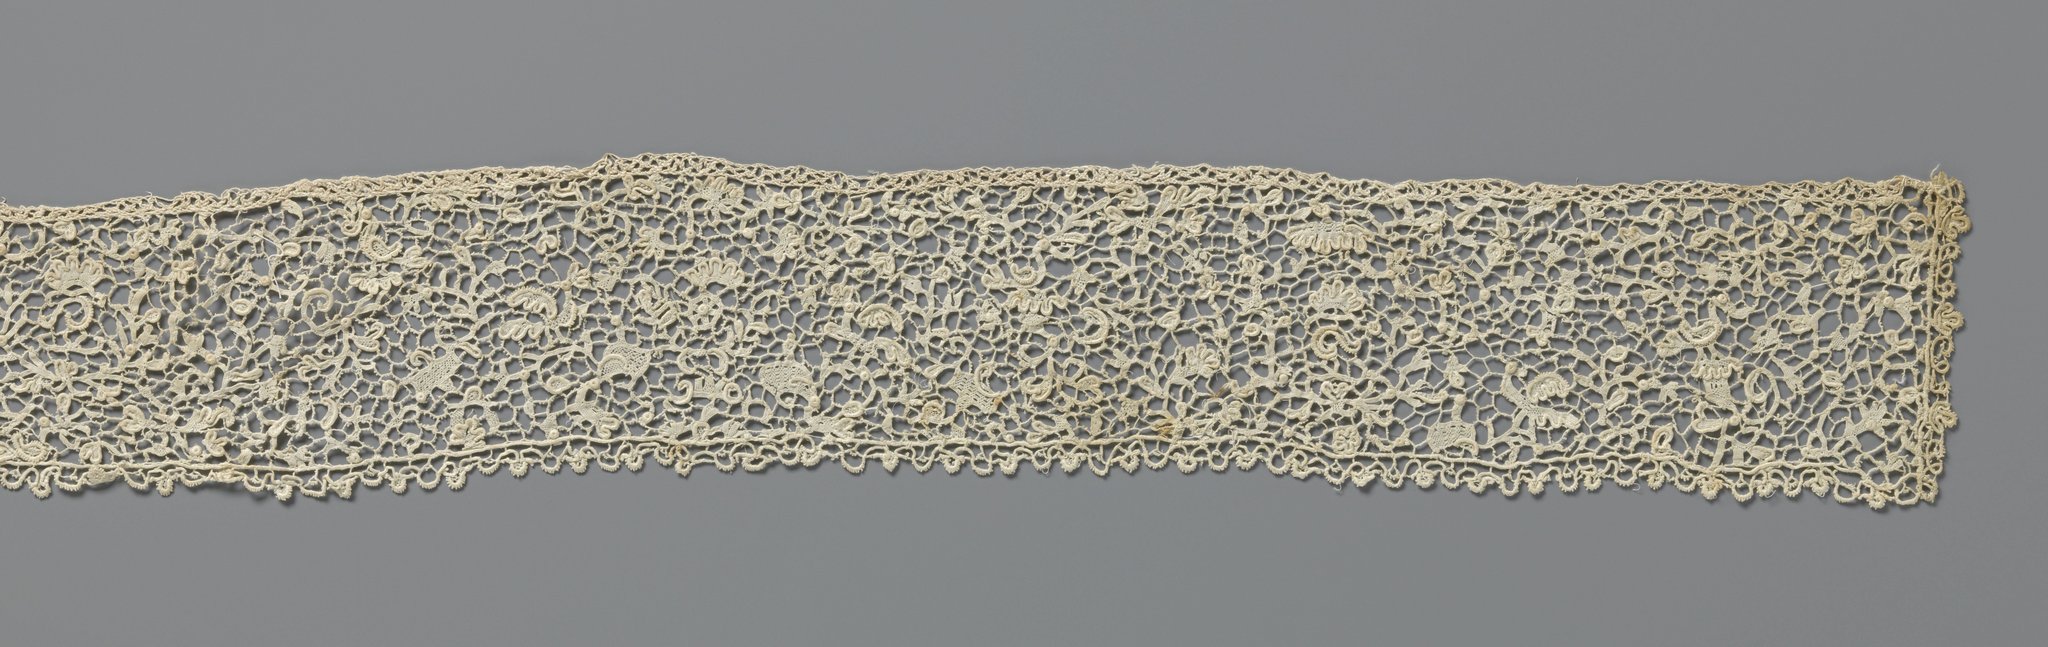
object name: strip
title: Strook naaldkant met vogels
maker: Anonymous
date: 1675-1699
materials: linen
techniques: needle lace, lace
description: Strook naturelkleurig naaldkant, point de France. Patroon zonder rapport maar met terugkerende motieven, waaronder kleine vogels, op een zeshoekige grond met gepicoteerde spijlen. Volwerk versierd met uitsparingen, motieven deels zonder en deels met kordons. Aan de rechte rand aan de onderzijde hangen kleine gepicoteerde boogjes. De zijkanten zijn met palmetjes afgewerkt. De bovenzijde is afgezet met een rand kloskant.